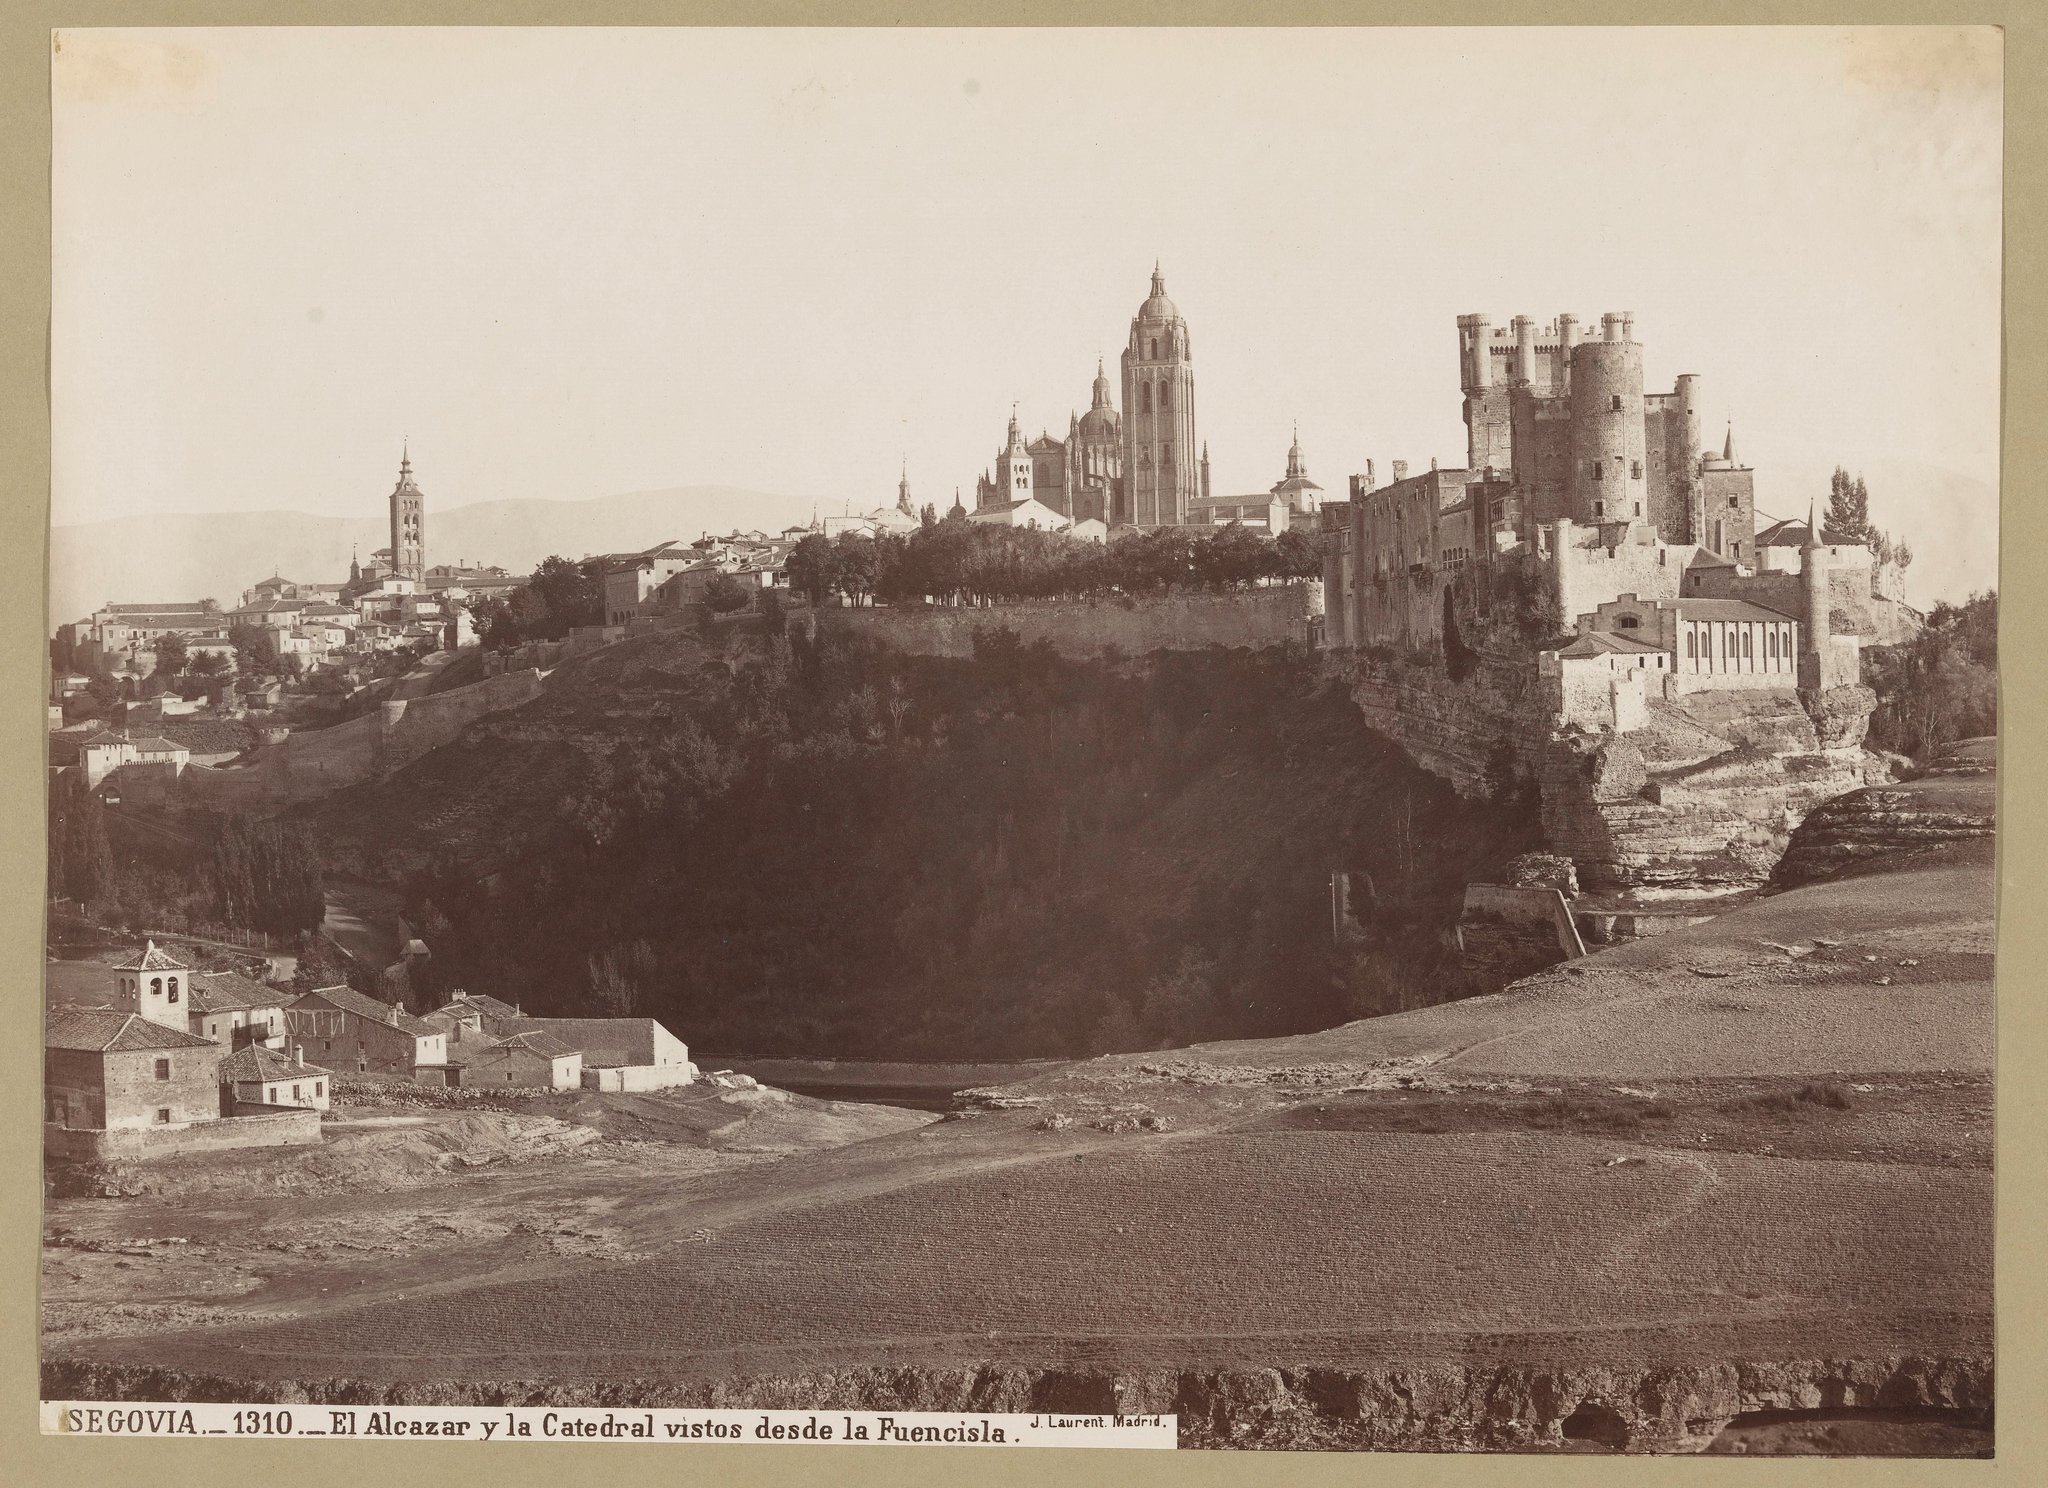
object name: photograph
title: Gezicht op het Alcázar van Segovia en de kathedraal van Segovia vanaf het Alameda de la Fuencisla, Spanje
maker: juan laurent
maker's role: publisher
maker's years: 1816-1896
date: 1856-1863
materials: paper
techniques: albumen print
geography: segovia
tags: city-view in general; 'veduta'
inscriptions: number: ‘1310’